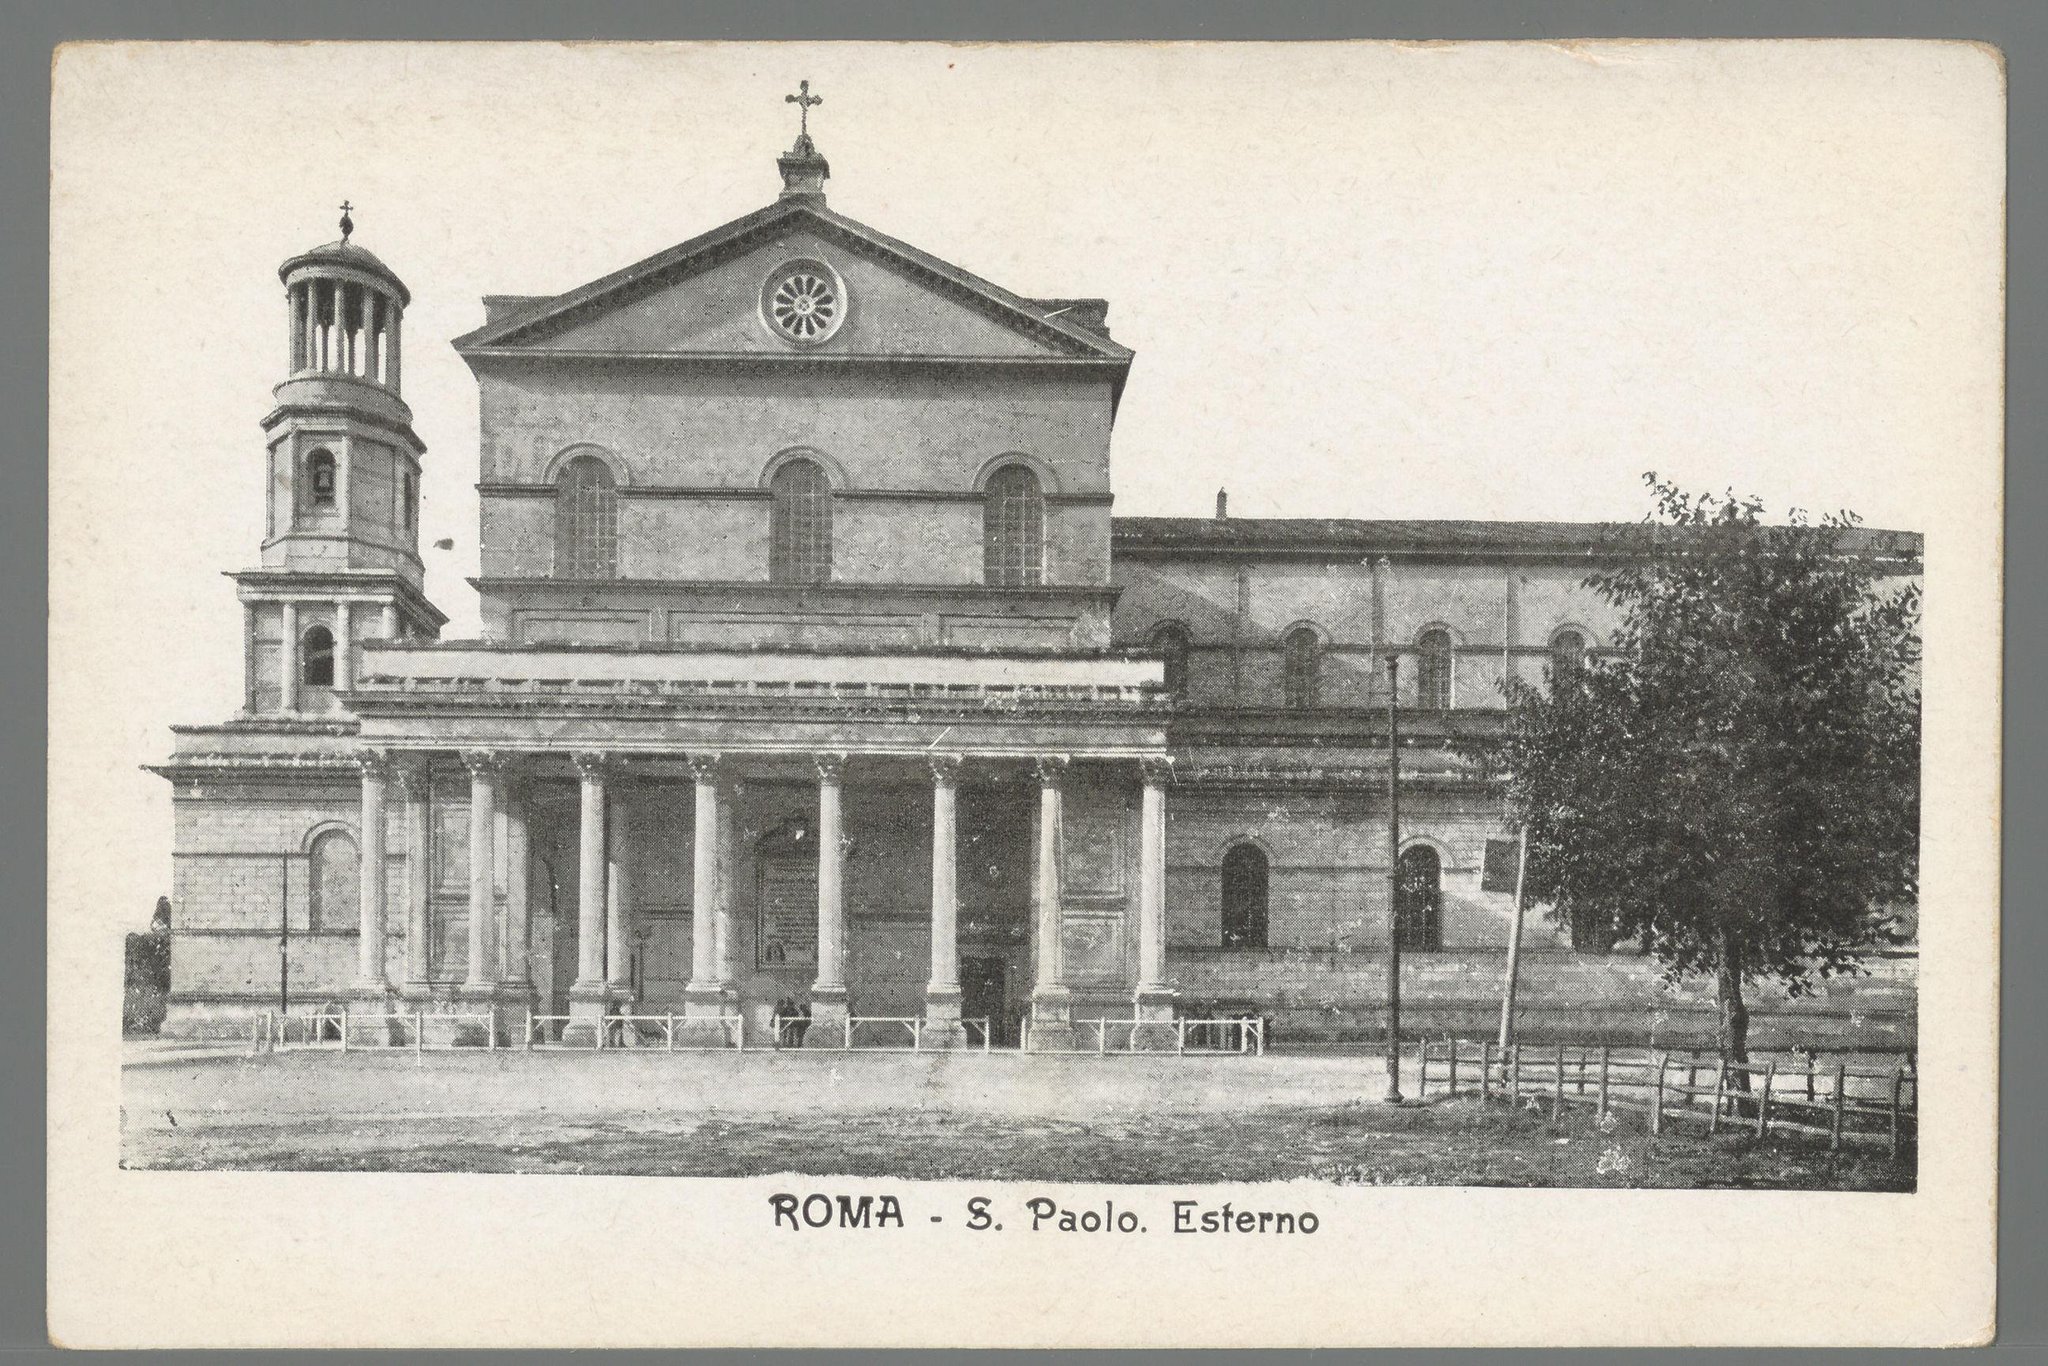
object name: photomechanical print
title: Roma. S. Paolo. Esterno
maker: Anonymous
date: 1906-1930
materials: cardboard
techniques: autotype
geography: rome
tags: church (exterior)